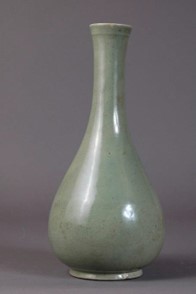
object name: vase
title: Celadon Flower Vase (Hanaire)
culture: japanese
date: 1634-1666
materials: ceramic glaze, glaze, porcelain